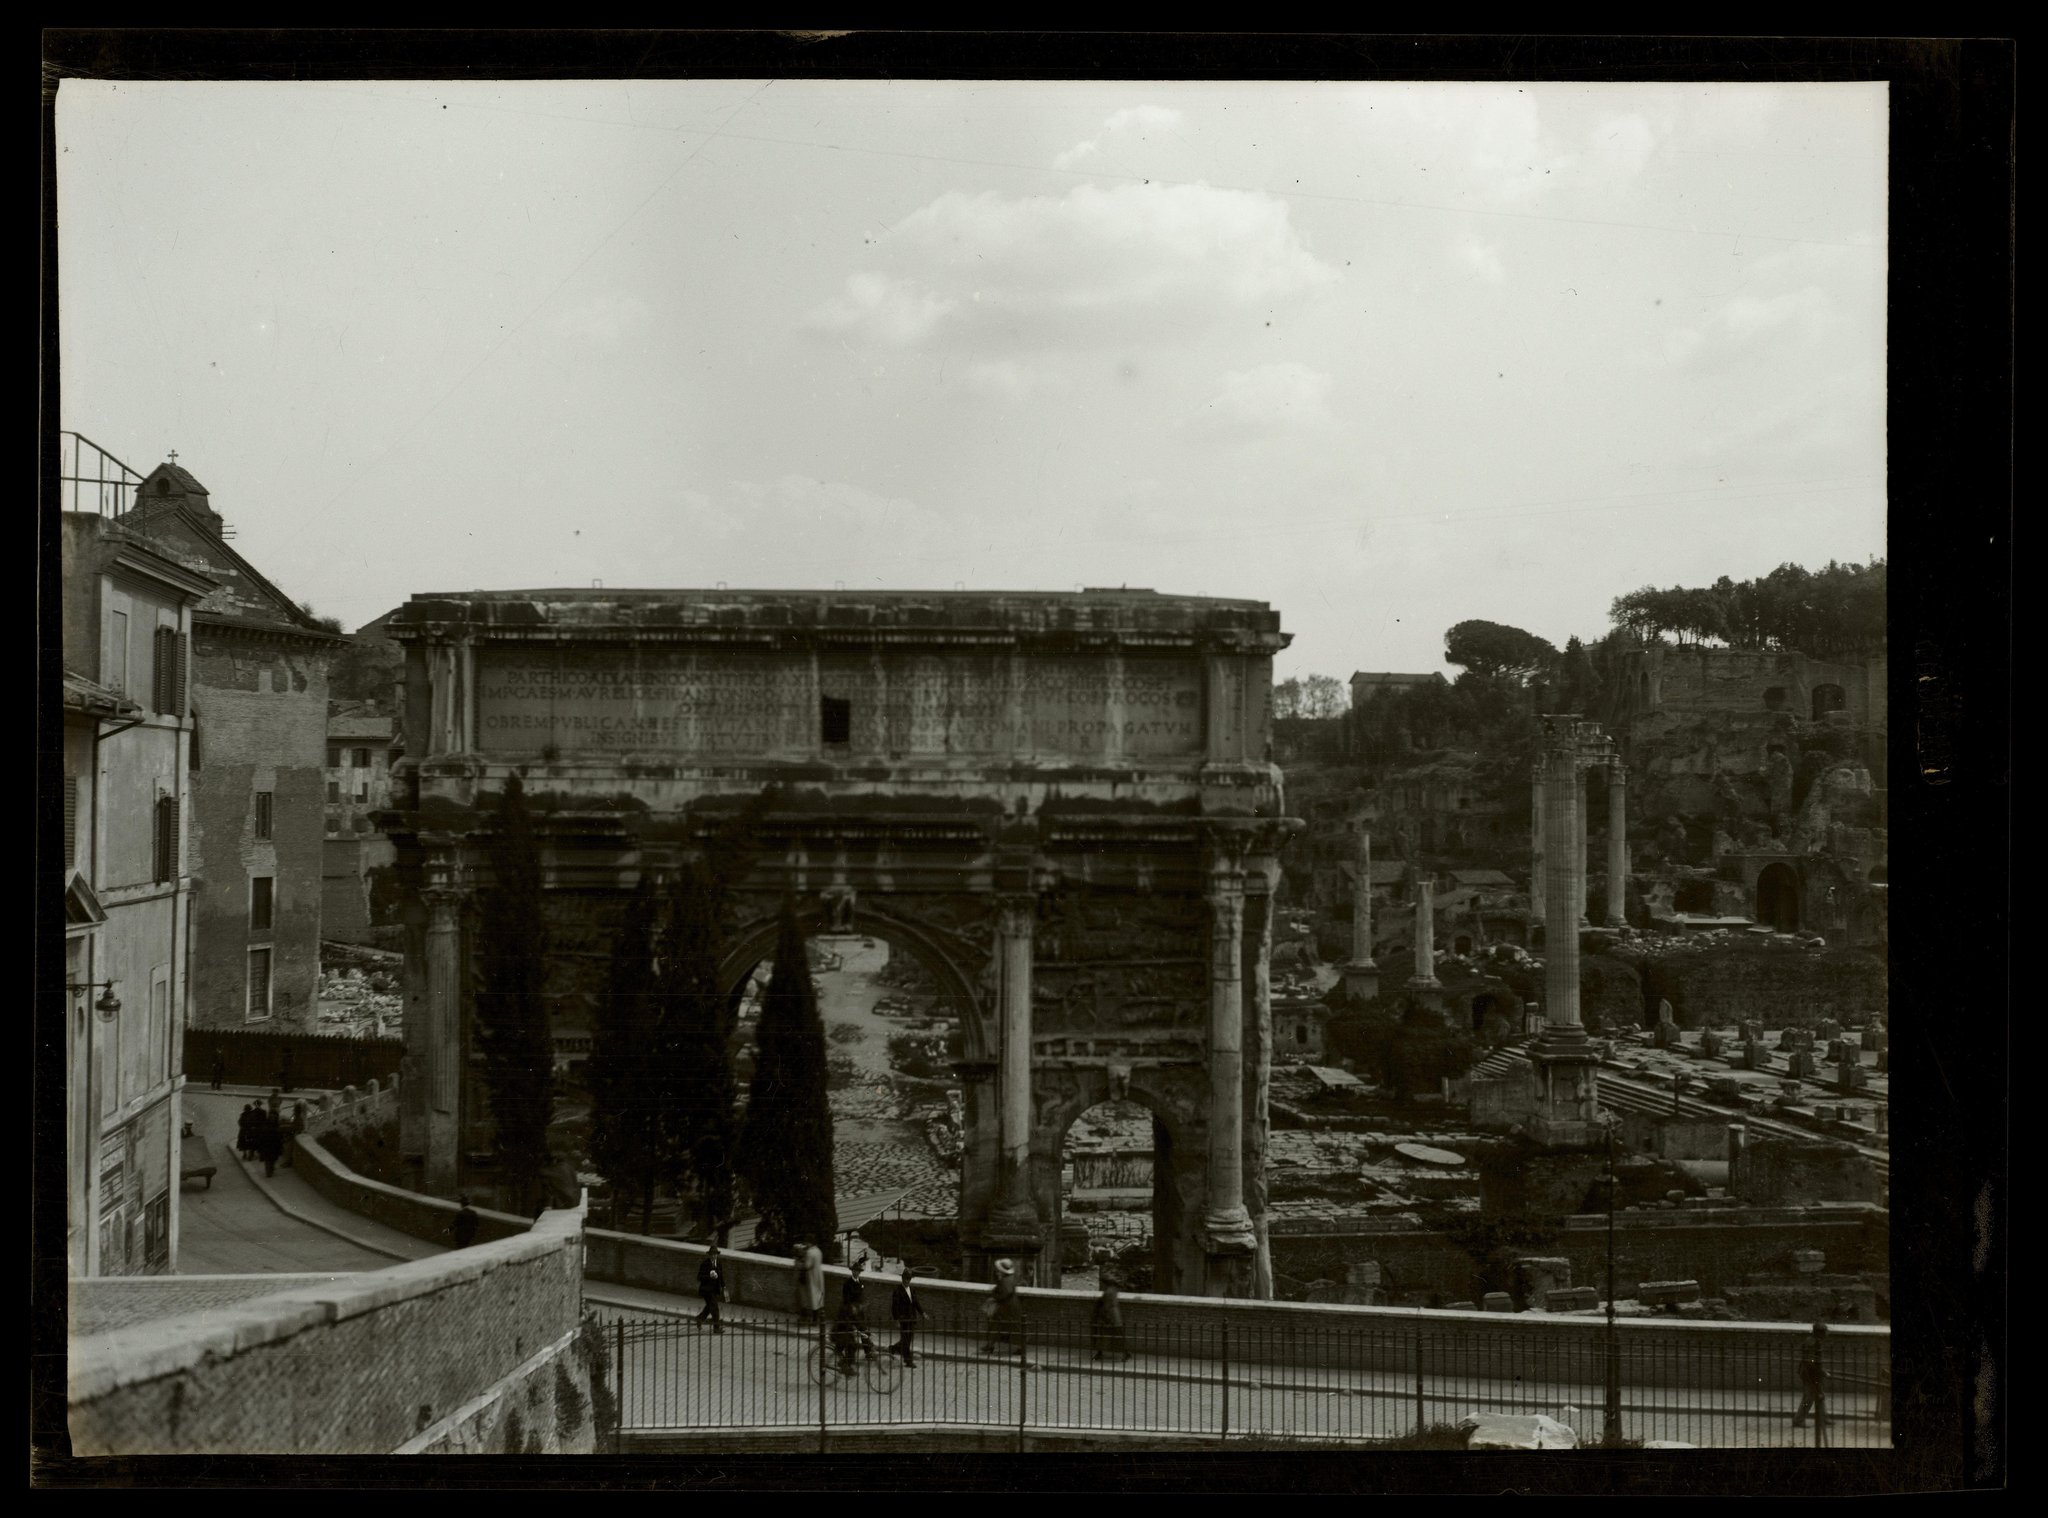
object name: negative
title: Filmnegatief met opname van Rome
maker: Anonymous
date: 1907-1935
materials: film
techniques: gelatin silver negative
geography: rome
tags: rome